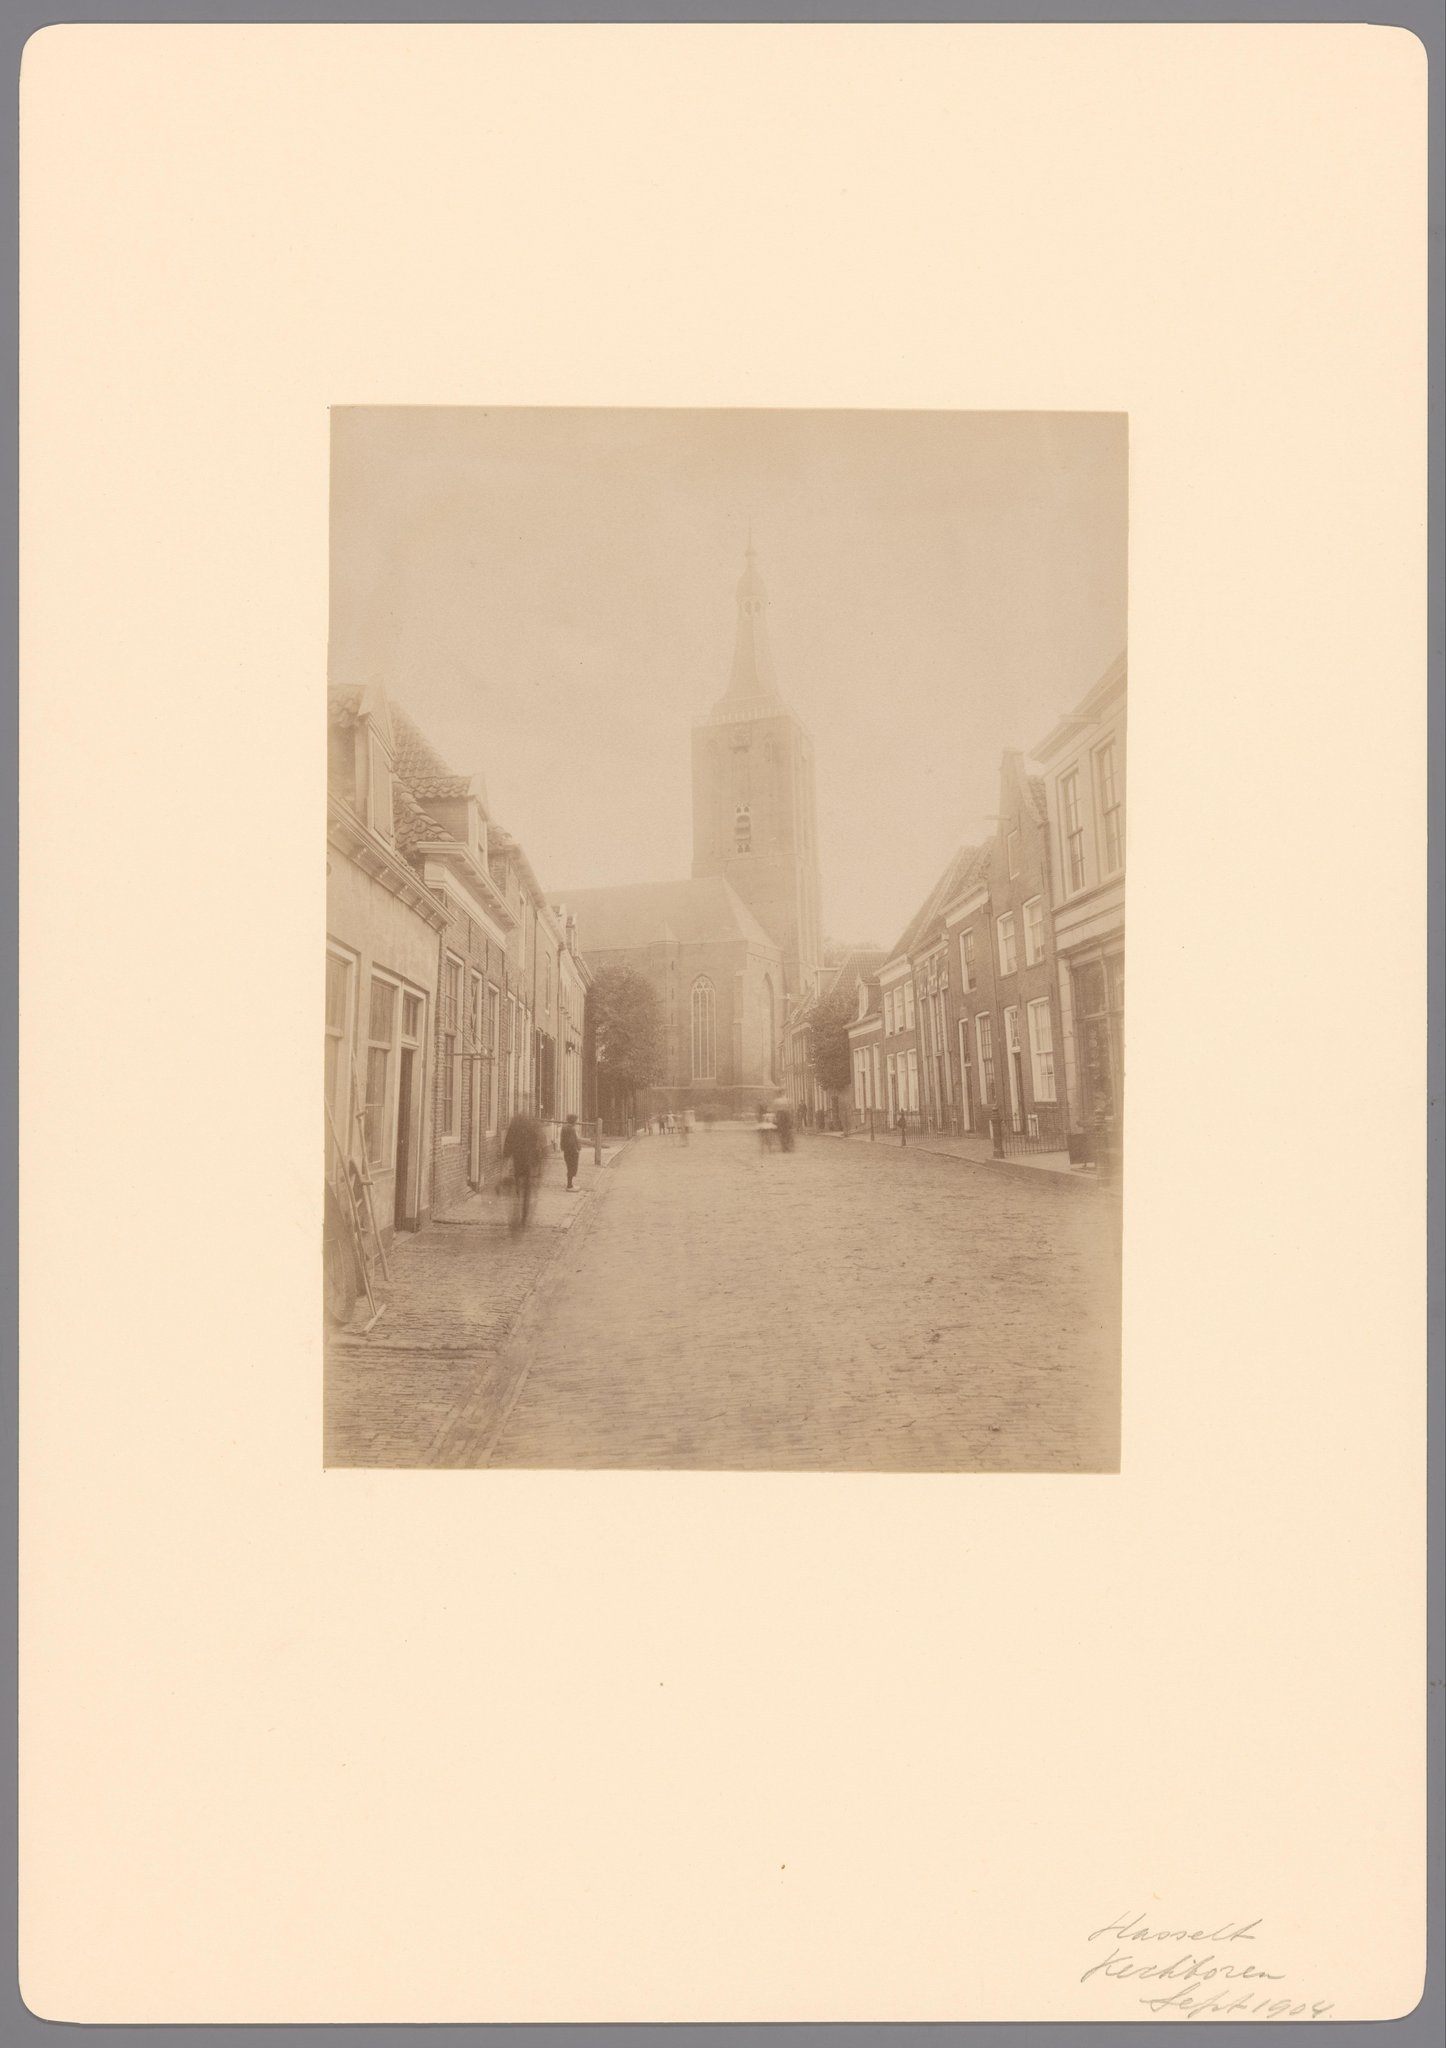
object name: photograph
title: Gezicht op de Grote of Sint-Stephanuskerk te Hasselt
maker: anoniem (monumentenzorg)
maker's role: fotograaf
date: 1904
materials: cardboard, photographic support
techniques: albumen print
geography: hasselt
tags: church (exterior), street (+ city(-scape) with figures, staffage)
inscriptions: annotation: ‘Hasselt/ kerktoren/ sept 1904’